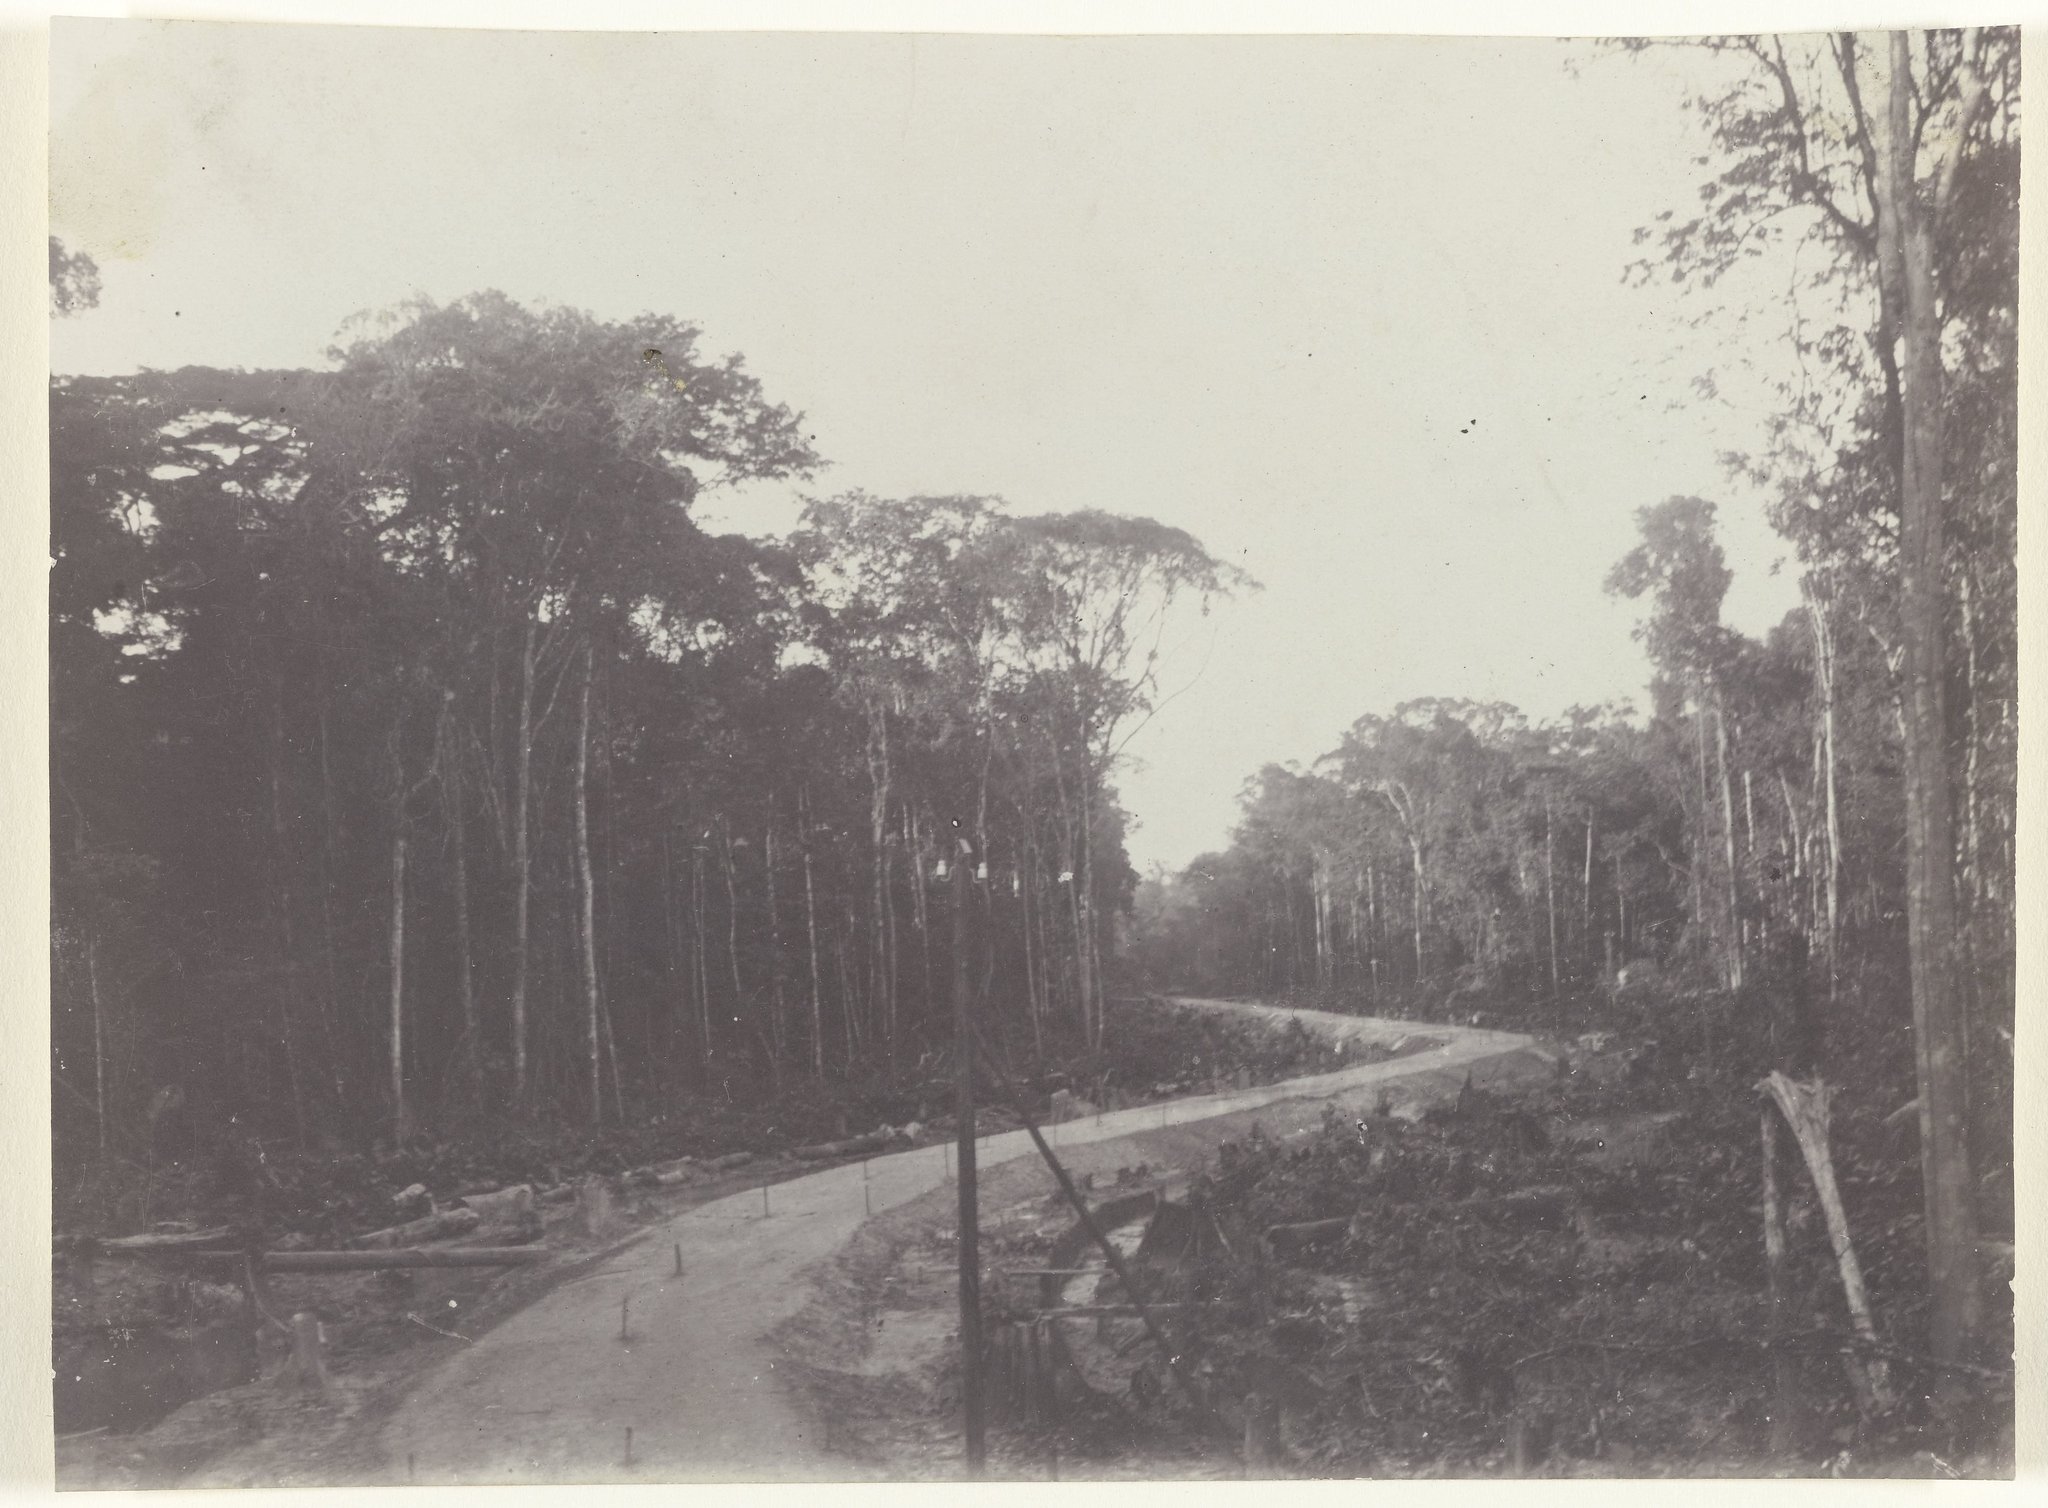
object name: photograph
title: Spooraanleg te Suriname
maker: Anonymous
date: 1916-1930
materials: photographic support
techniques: photography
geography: suriname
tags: amsterdam, theodoor brouwers, suriname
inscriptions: inscription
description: Slingerende weg door een bos voor een spoorlijn.